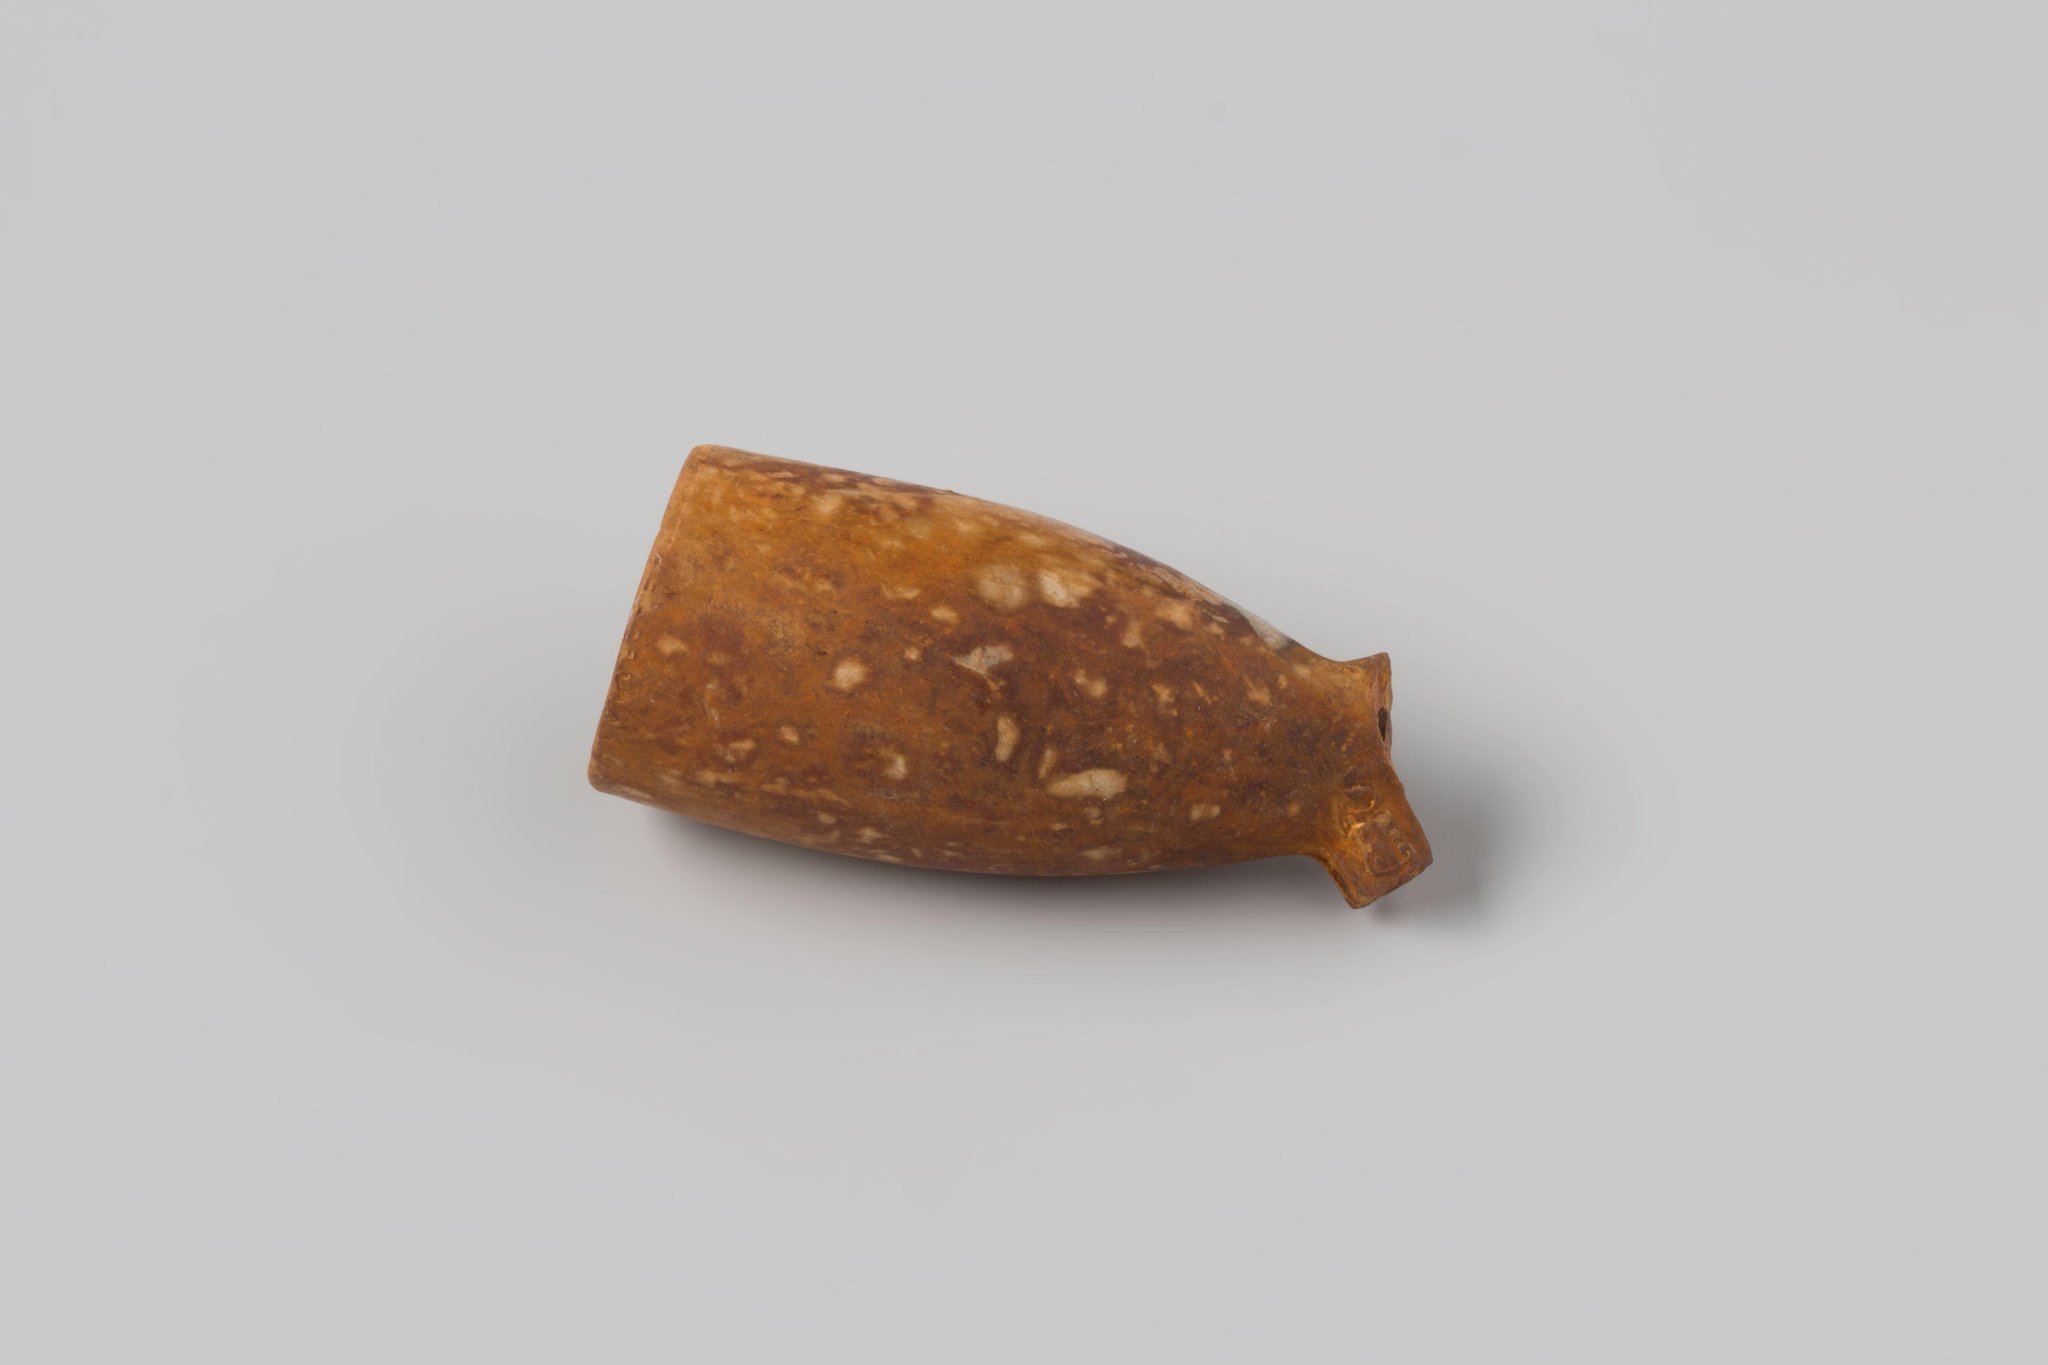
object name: pipe bowl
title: Pijpenkop uit het wrak van de Oost-Indiëvaarder Hollandia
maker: Anonymous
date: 1700-1743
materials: clay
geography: netherlands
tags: verenigde oostindische compagnie, hollandia (schip), annet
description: Pipe, bowl, heelmark: mermaid; fragm, no hsm, eroded.